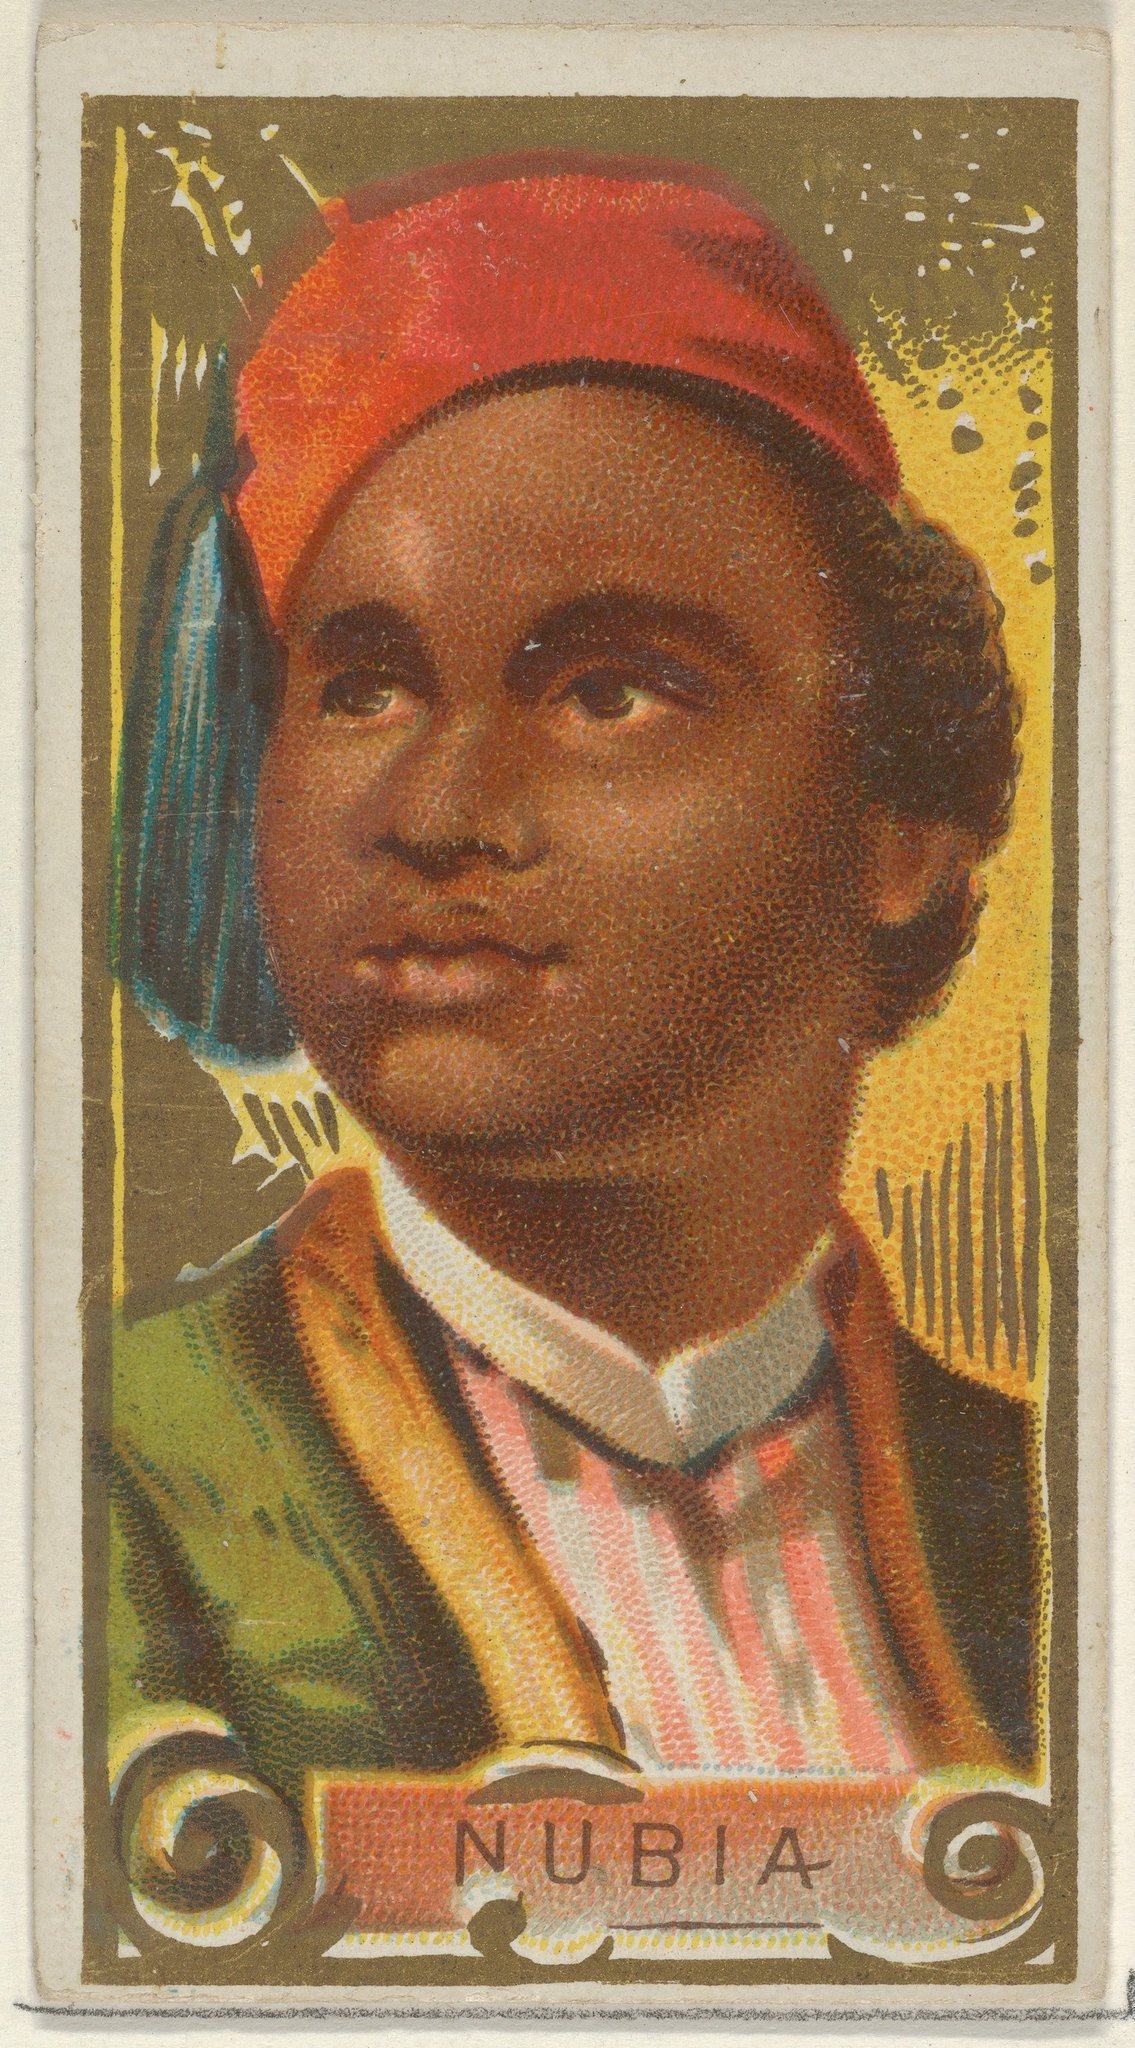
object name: print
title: Nubia, from the Types of All Nations series (N24) for Allen & Ginter Cigarettes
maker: allen & ginter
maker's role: publisher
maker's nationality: american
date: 1889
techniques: color lithograph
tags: men